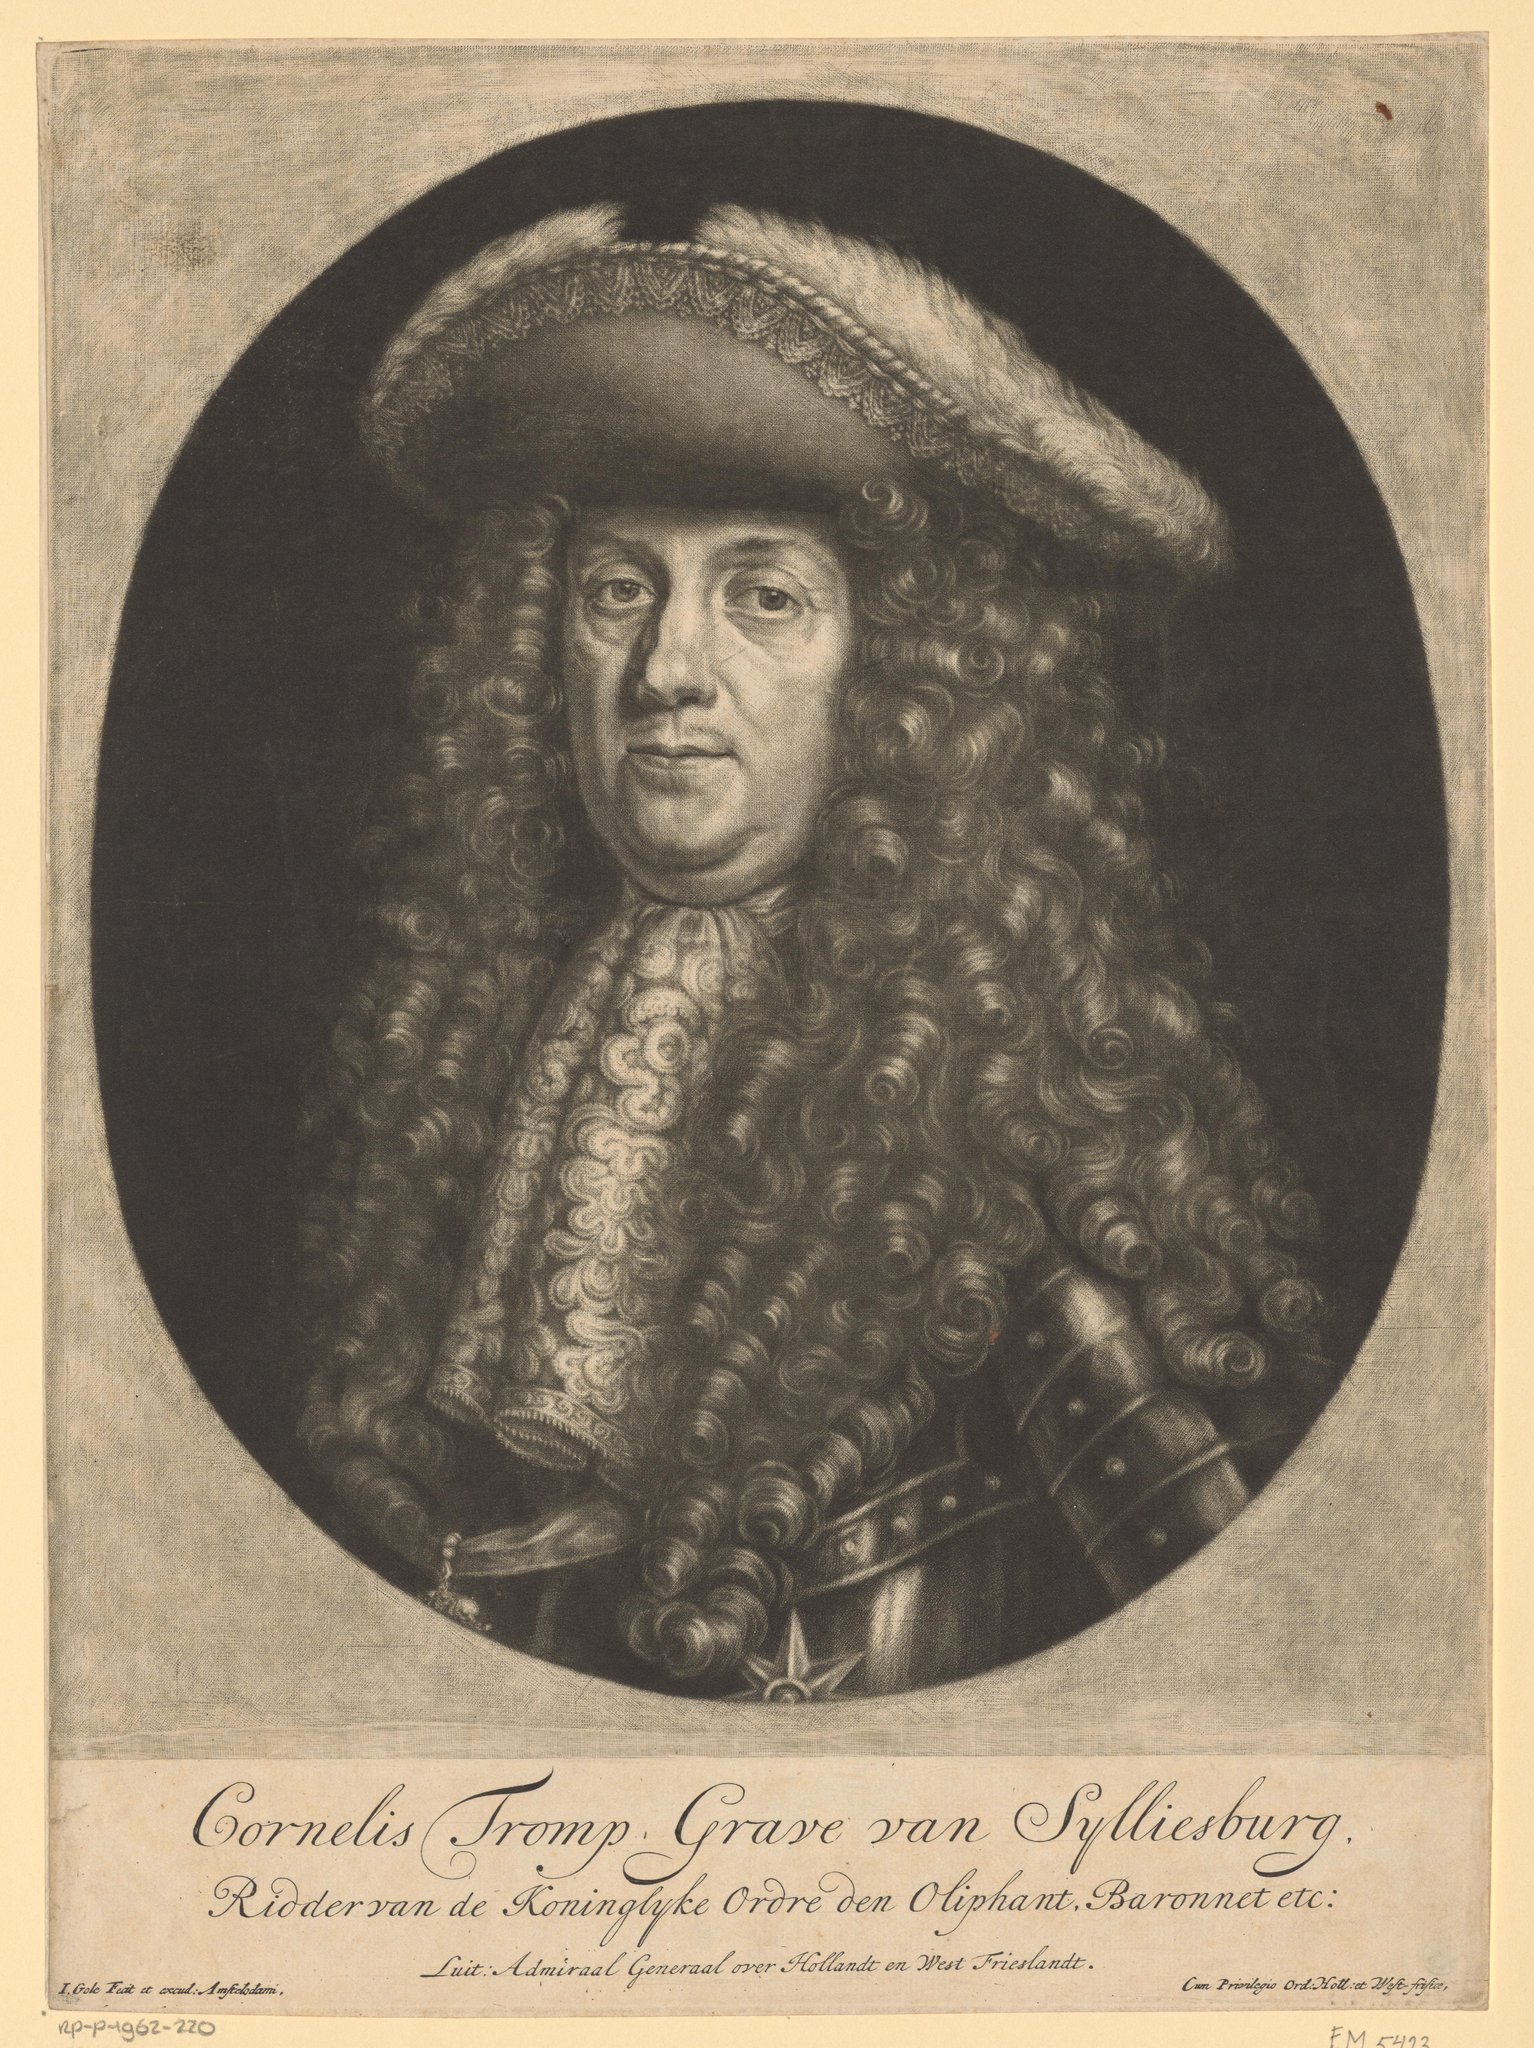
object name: print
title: Portret van Cornelis Tromp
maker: jacob gole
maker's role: print maker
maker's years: 1660-1724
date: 1679-1724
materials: paper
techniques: mezzotint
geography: amsterdam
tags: rotterdam, amsterdam, cornelis tromp, armour, historical persons, commander-in-chief, admiral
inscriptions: collector's mark: Lugt 151